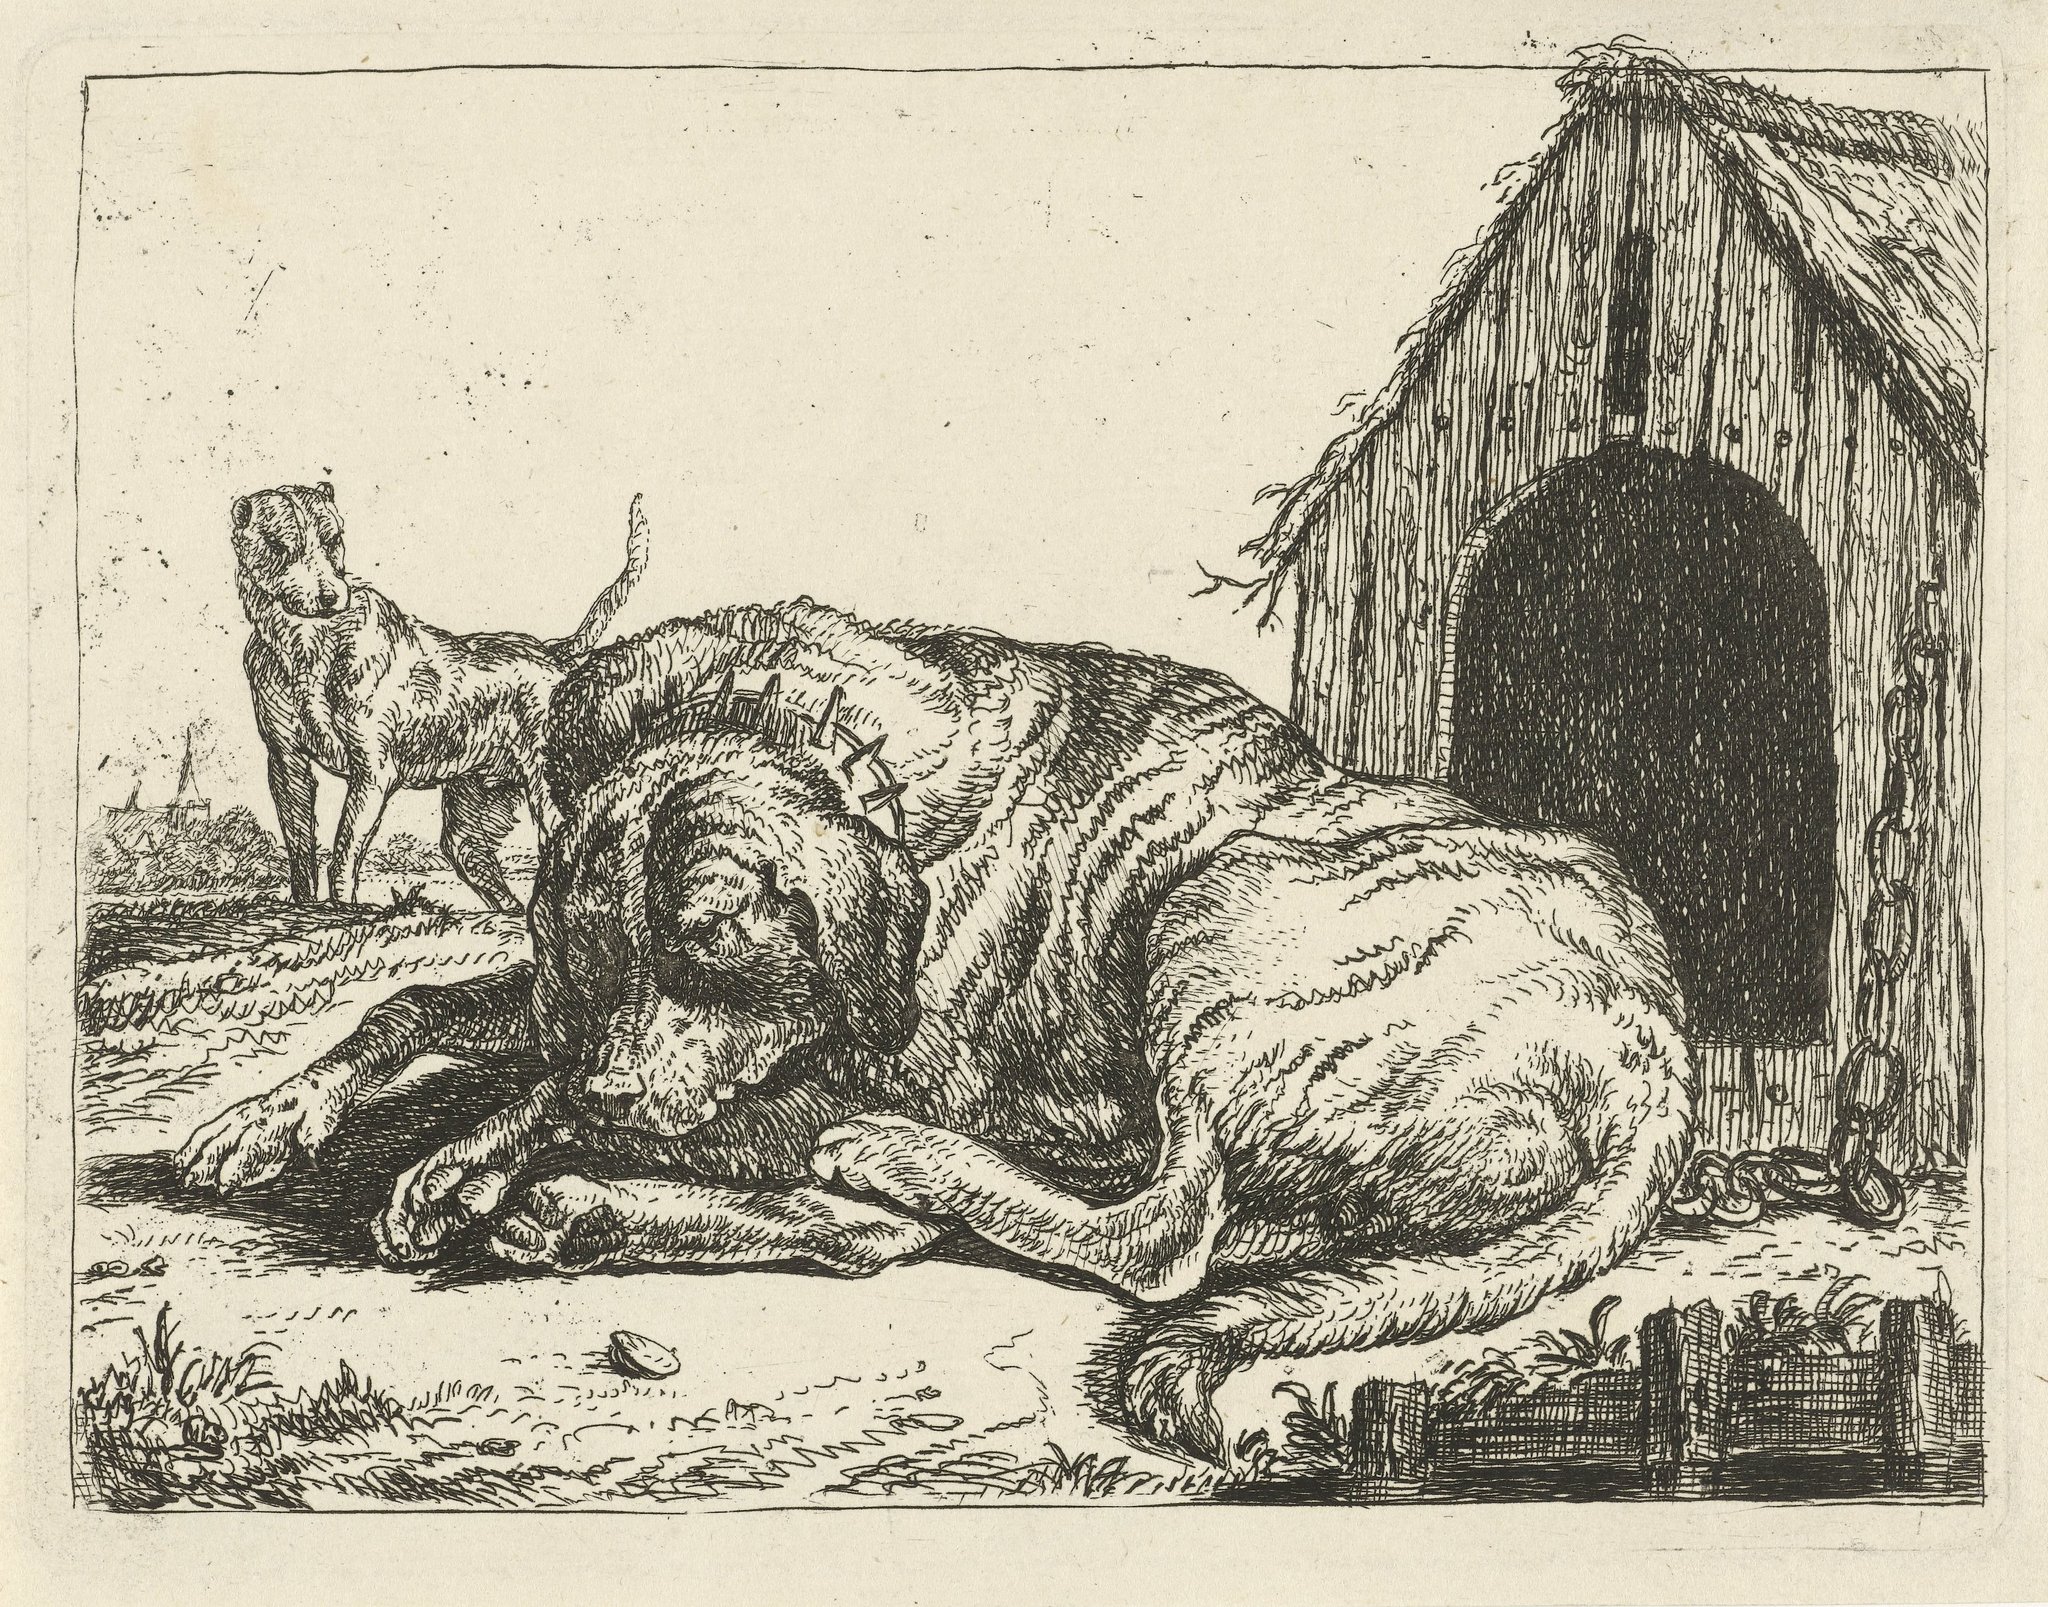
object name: print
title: Liggende hond aan een ketting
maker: pauwels van hillegaert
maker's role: painter, print maker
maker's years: 1596-1658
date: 1606-1658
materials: paper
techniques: etching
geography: amsterdam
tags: dog, dog (+ stable, shed, kennel)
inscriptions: collector's mark: Lugt 2228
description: Liggende hond aan een ketting voor een hondenhok. Op de achtergrond een tweede hond. Eerste prent van een serie van vier prenten met voorstellingen van honden.